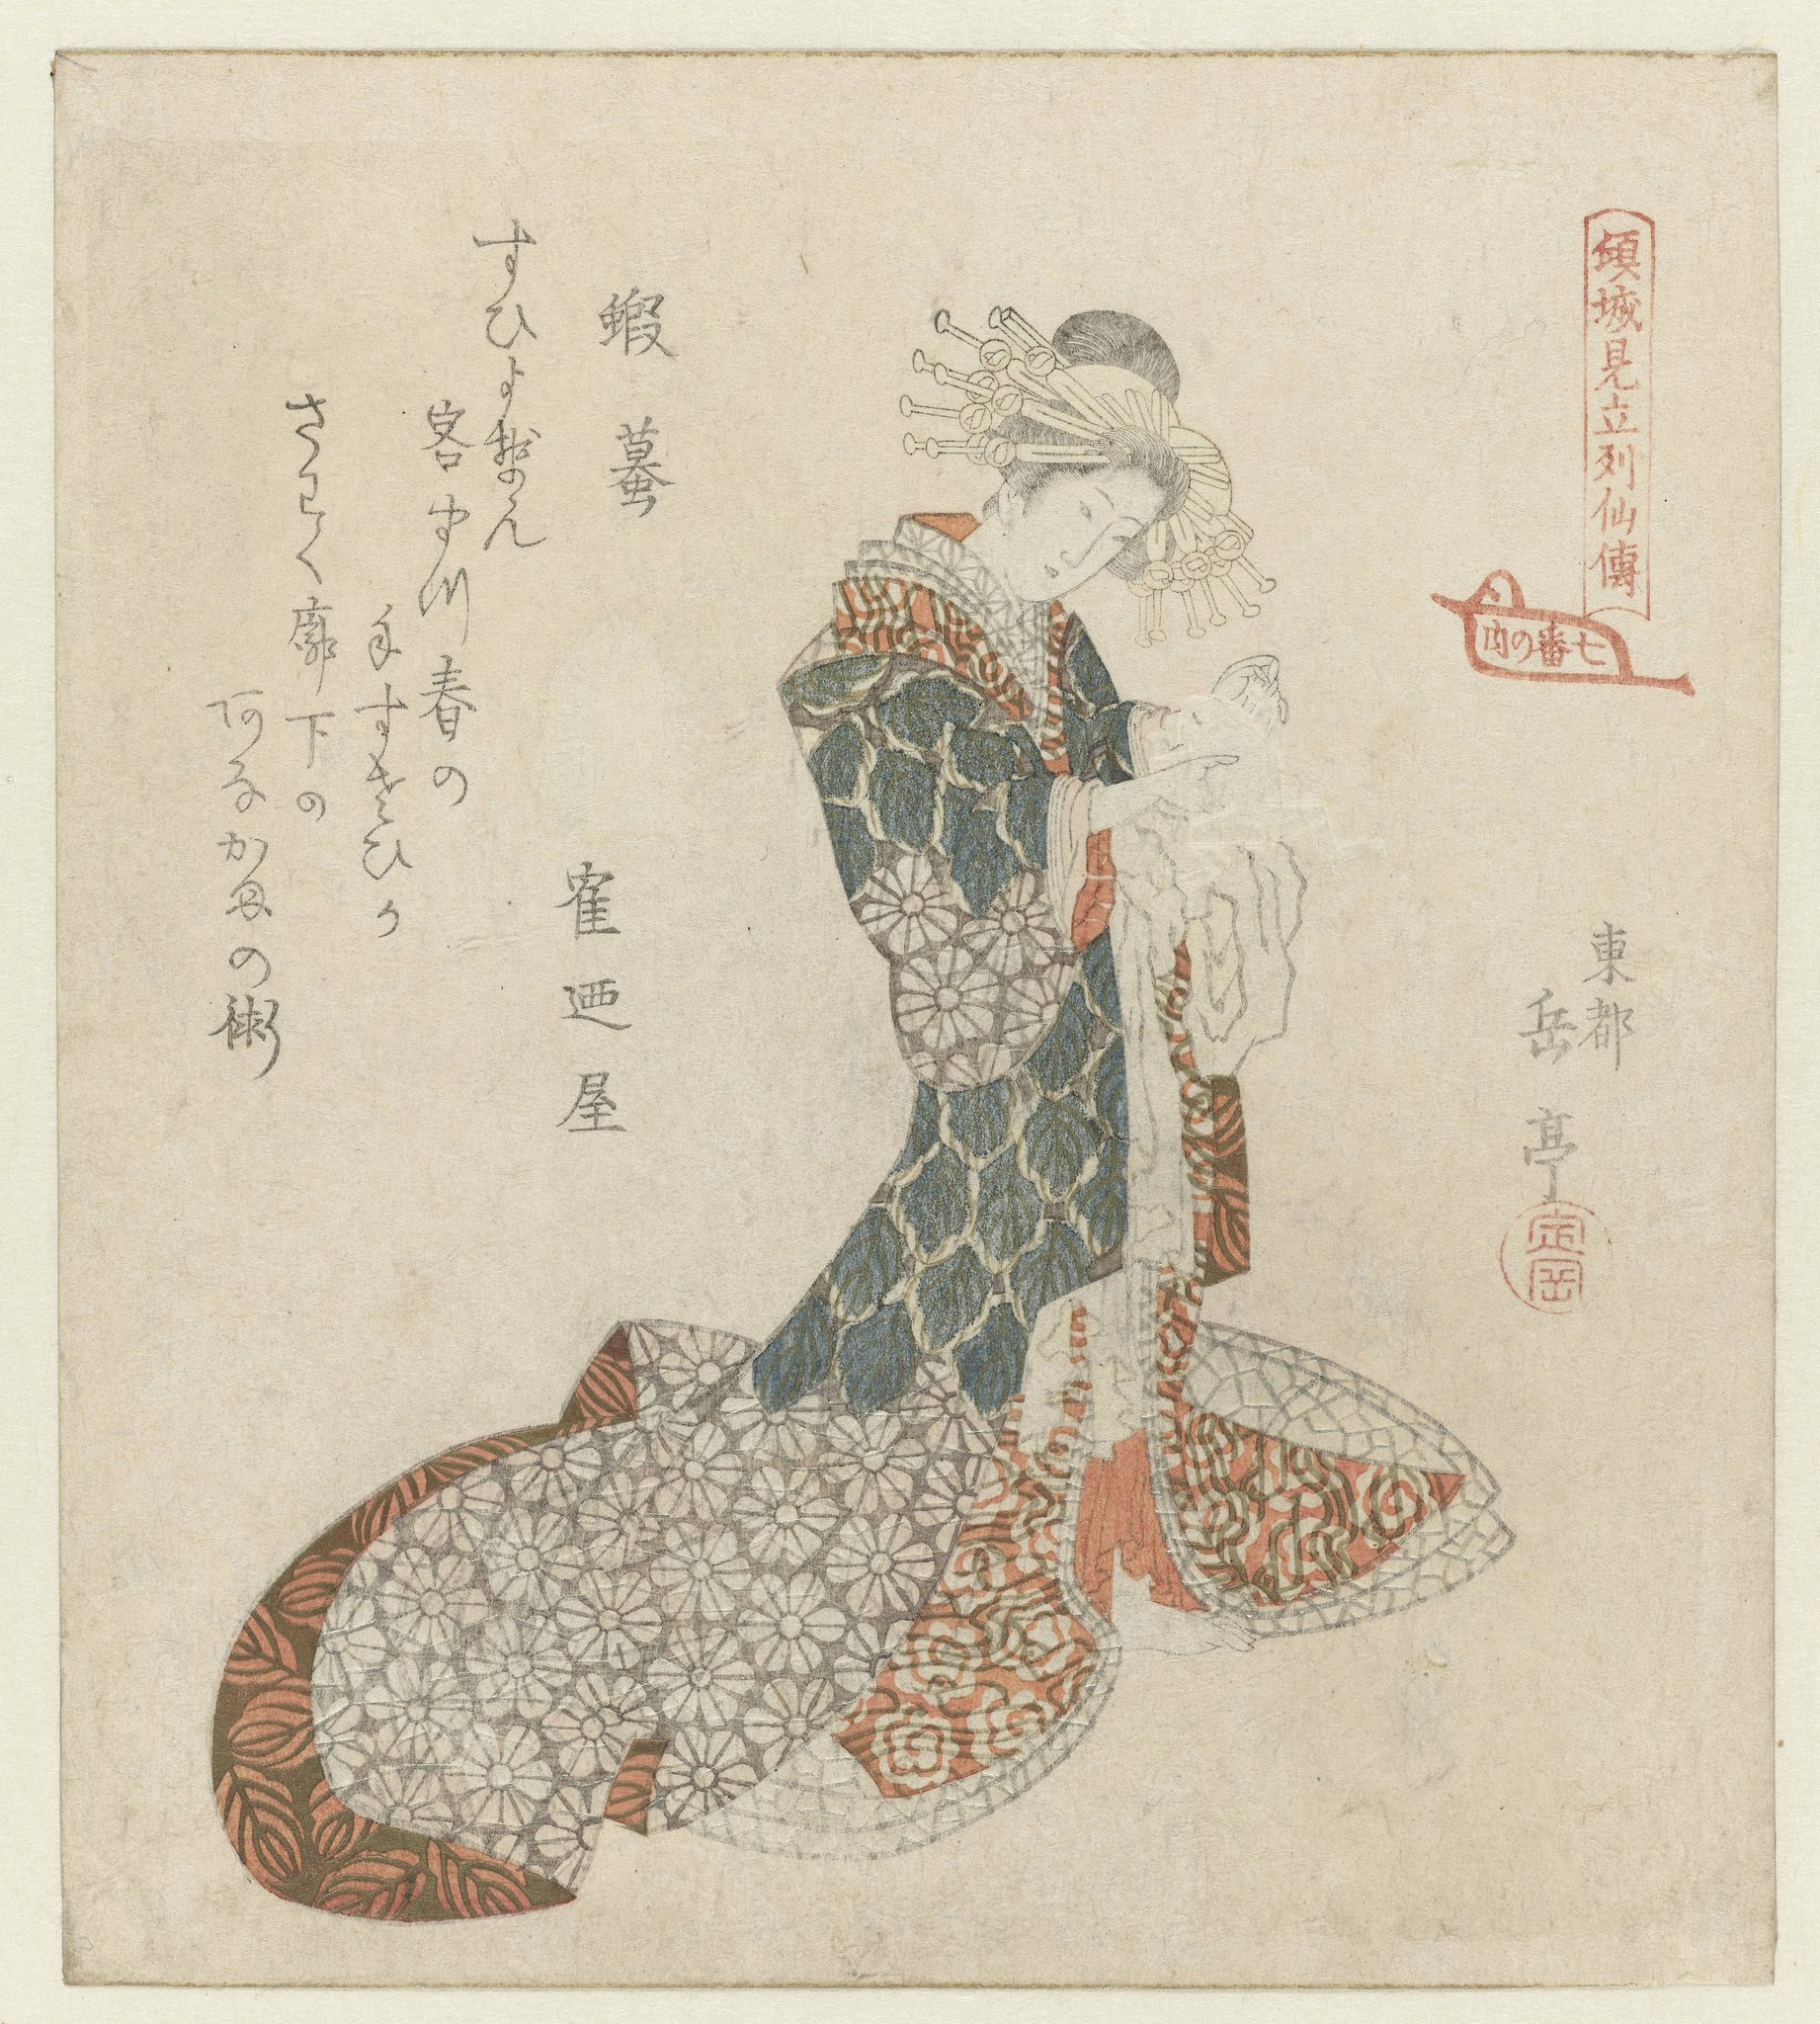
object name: surimono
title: De onsterfelijke Gama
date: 1821-1822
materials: paper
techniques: blind stamped, woodcut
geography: japan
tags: courtesan, hetaera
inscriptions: collector's mark, passe-partout, bottom left, printed: JABdH with a rooster., collector's mark, verso, stamped: Lugt 2228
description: Een surimono is een luxe uitgevoerde prent waarop beeld met één of meerdere gedichten gecombineerd is. Bij het drukken van een surimono werd vaak gebruik gemaakt van dikker papier, blinddruk en metaal pigmenten, zoals koper- en zilverpoeder. De prenten werden vaak in opdracht van dichters gemaakt en als exclusief geschenk aan vrienden en relaties gegeven.